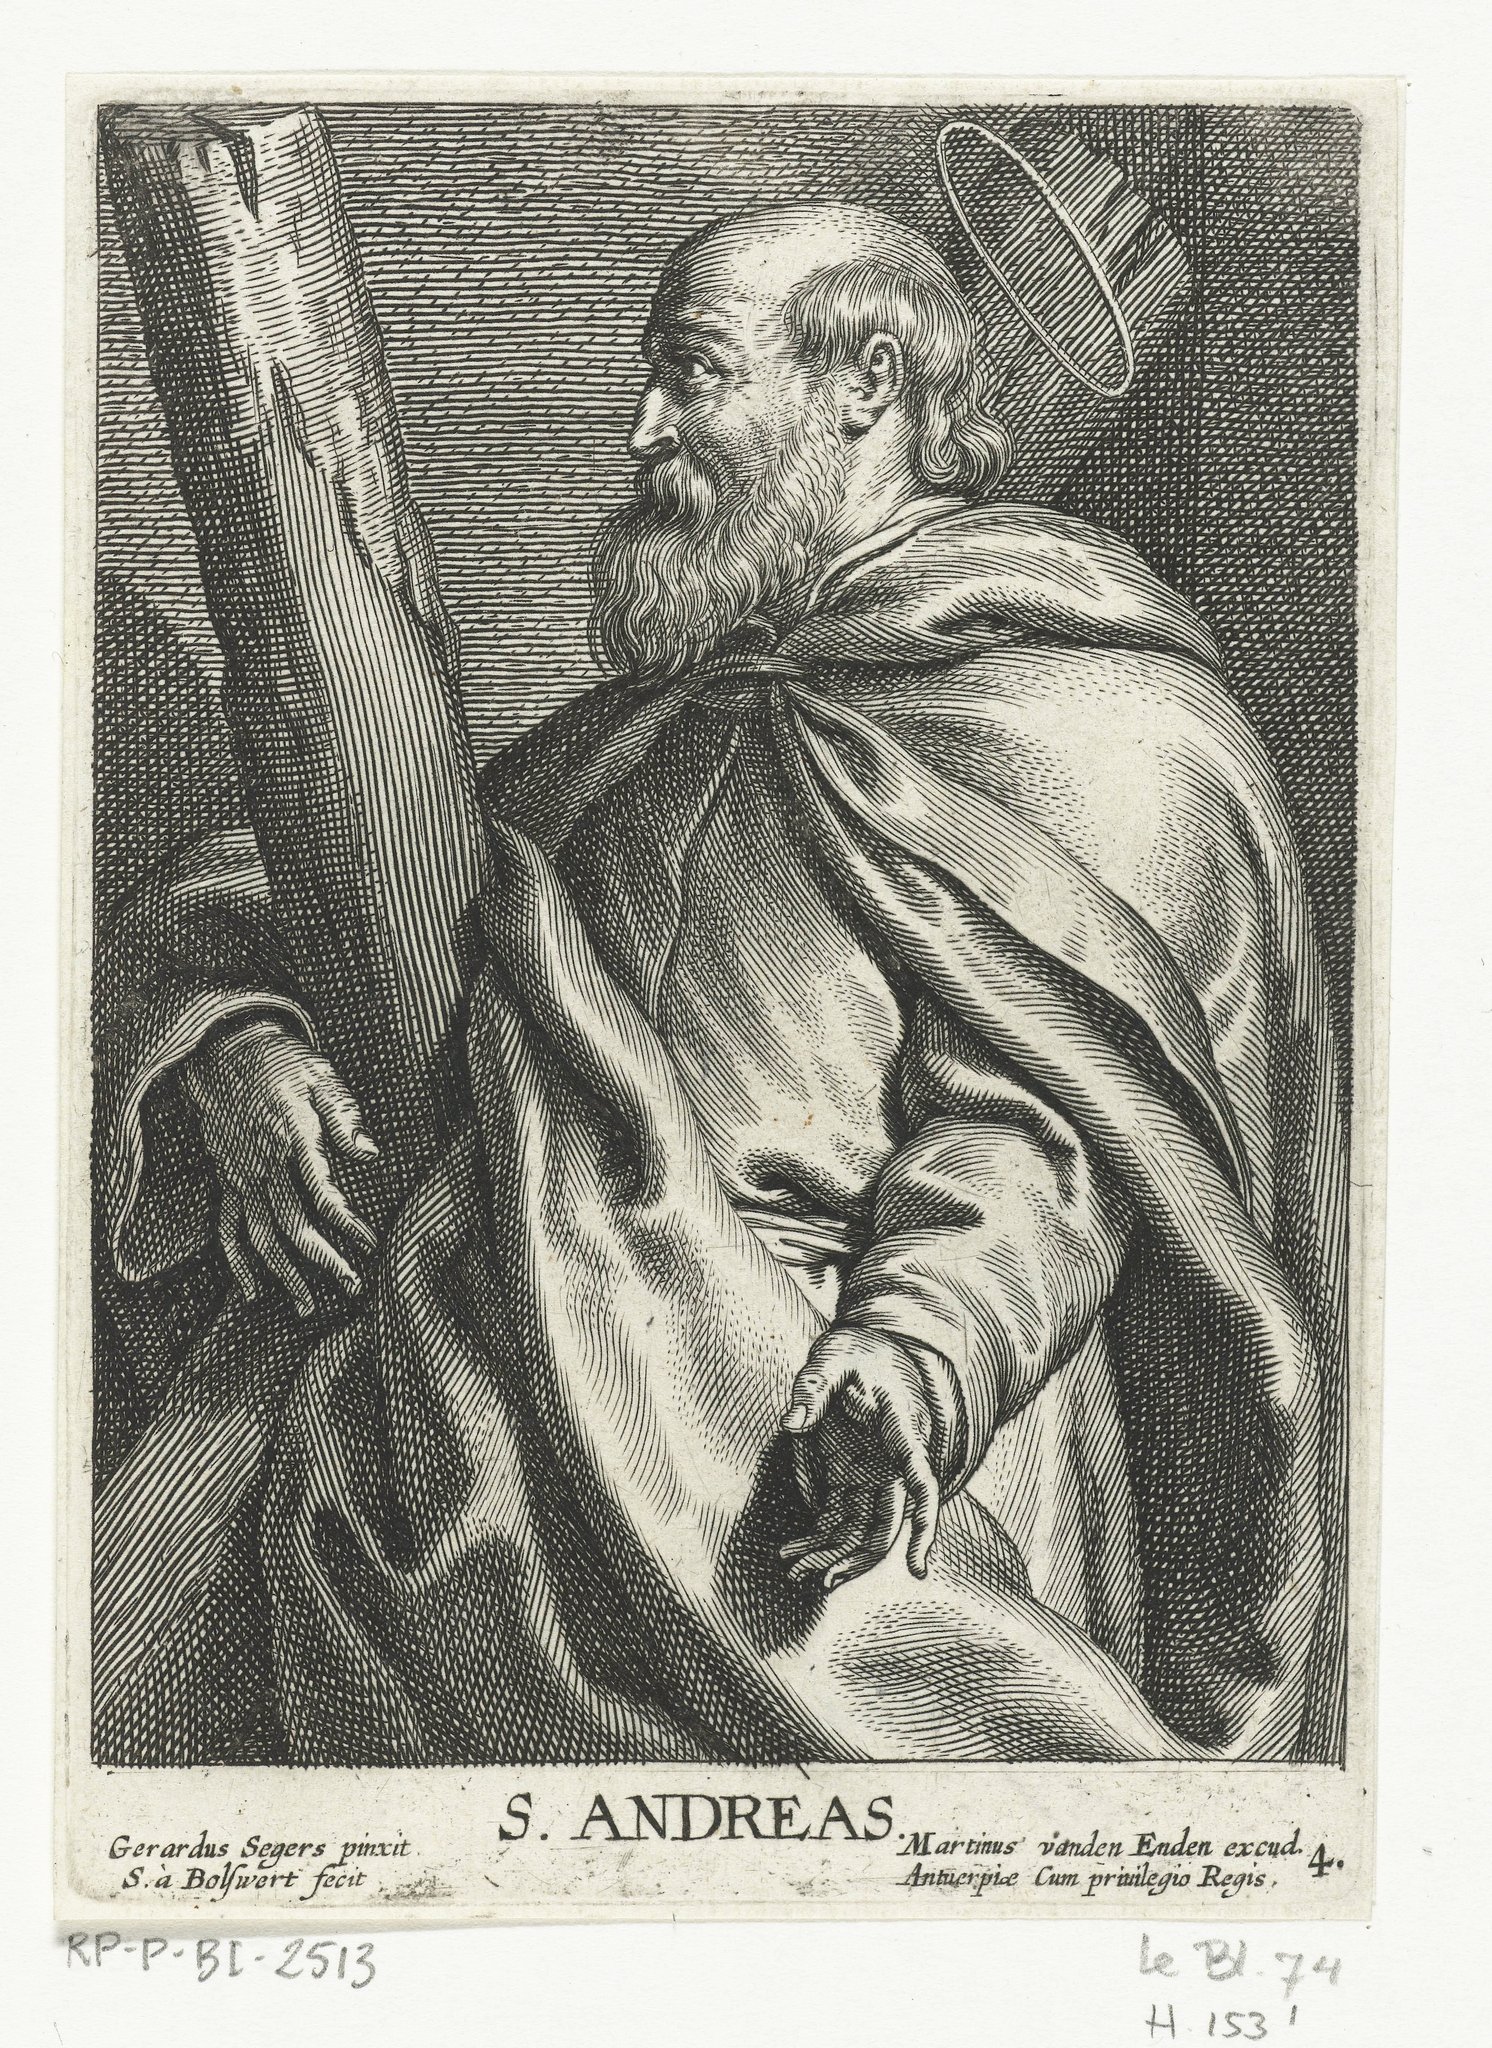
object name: print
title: S. Andreas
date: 1596-1659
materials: paper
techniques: engraving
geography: antwerp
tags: the apostle andrew; possible attributes: book, x-shaped cross, fish, fishing-net, rope, scroll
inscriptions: collector's mark: Lugt 240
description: Prent uit serie met veertien prenten met Christus, Paulus en twaalf apostelen naar schilderijen van Gerard Seghers.